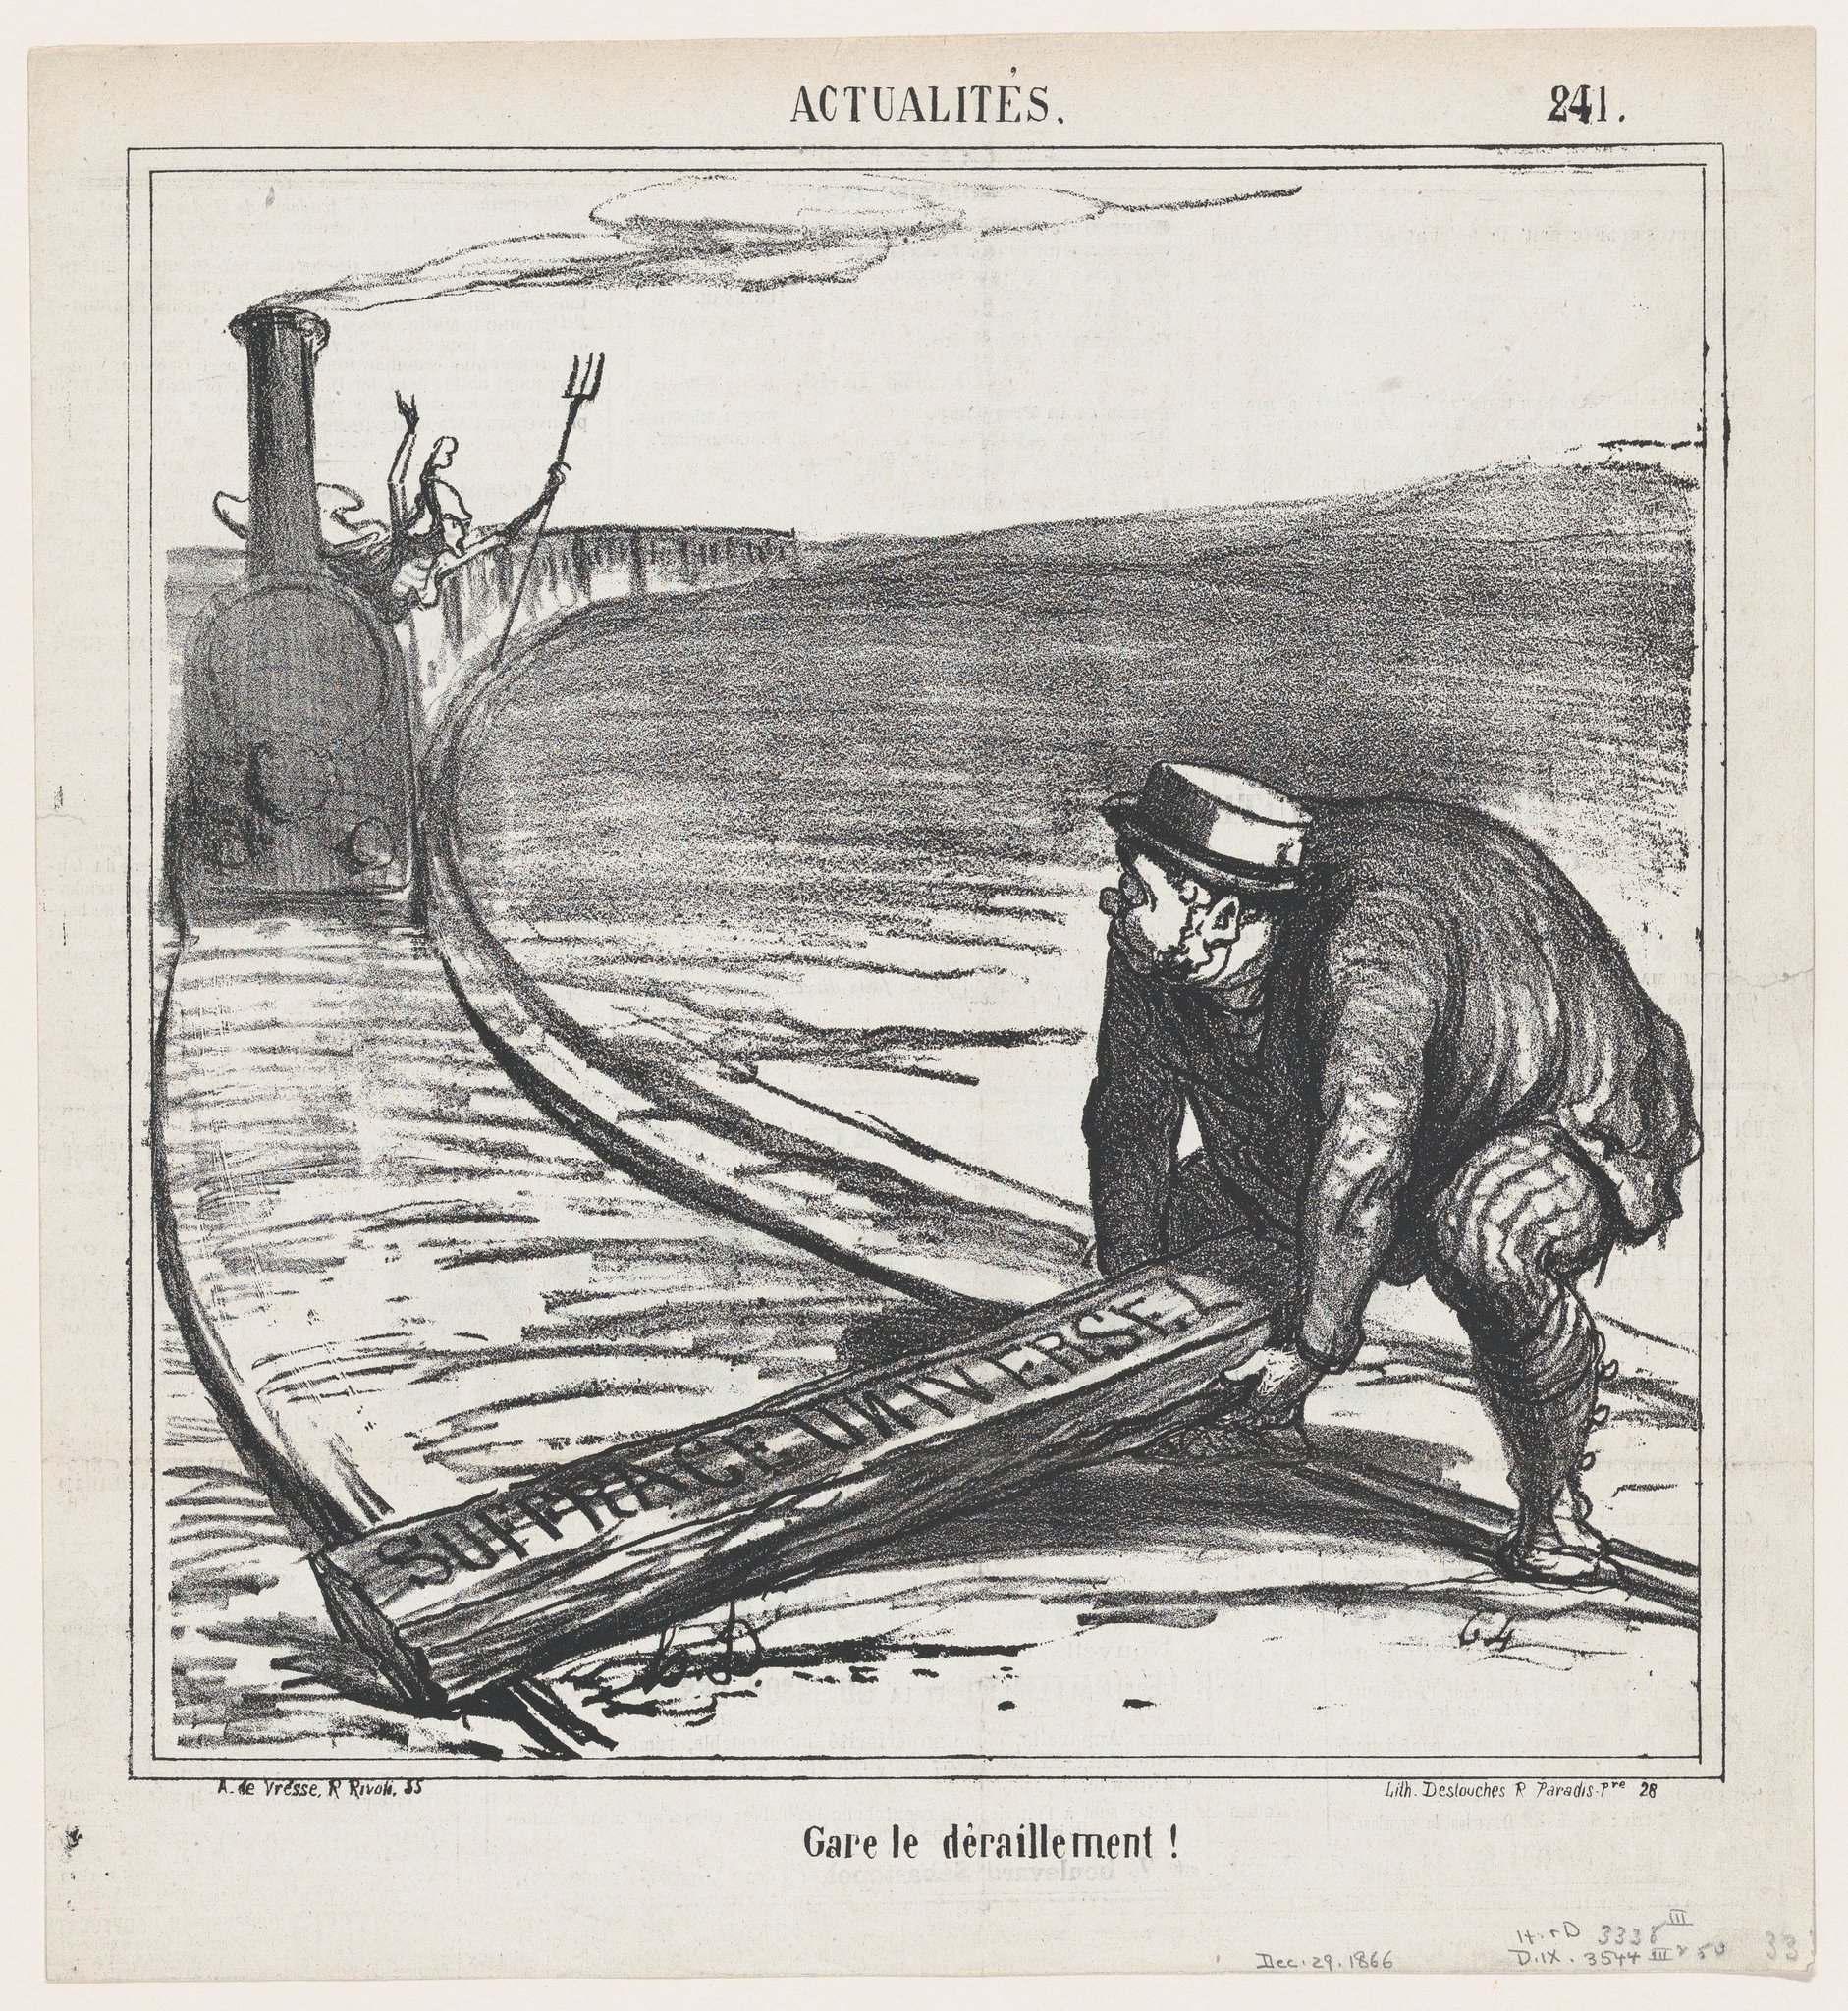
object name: print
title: Beware of Derailment!, from "News of the Day"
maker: honoré daumier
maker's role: artist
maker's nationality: french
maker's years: 1808-1879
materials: paper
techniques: lithograph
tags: railways,men,trains